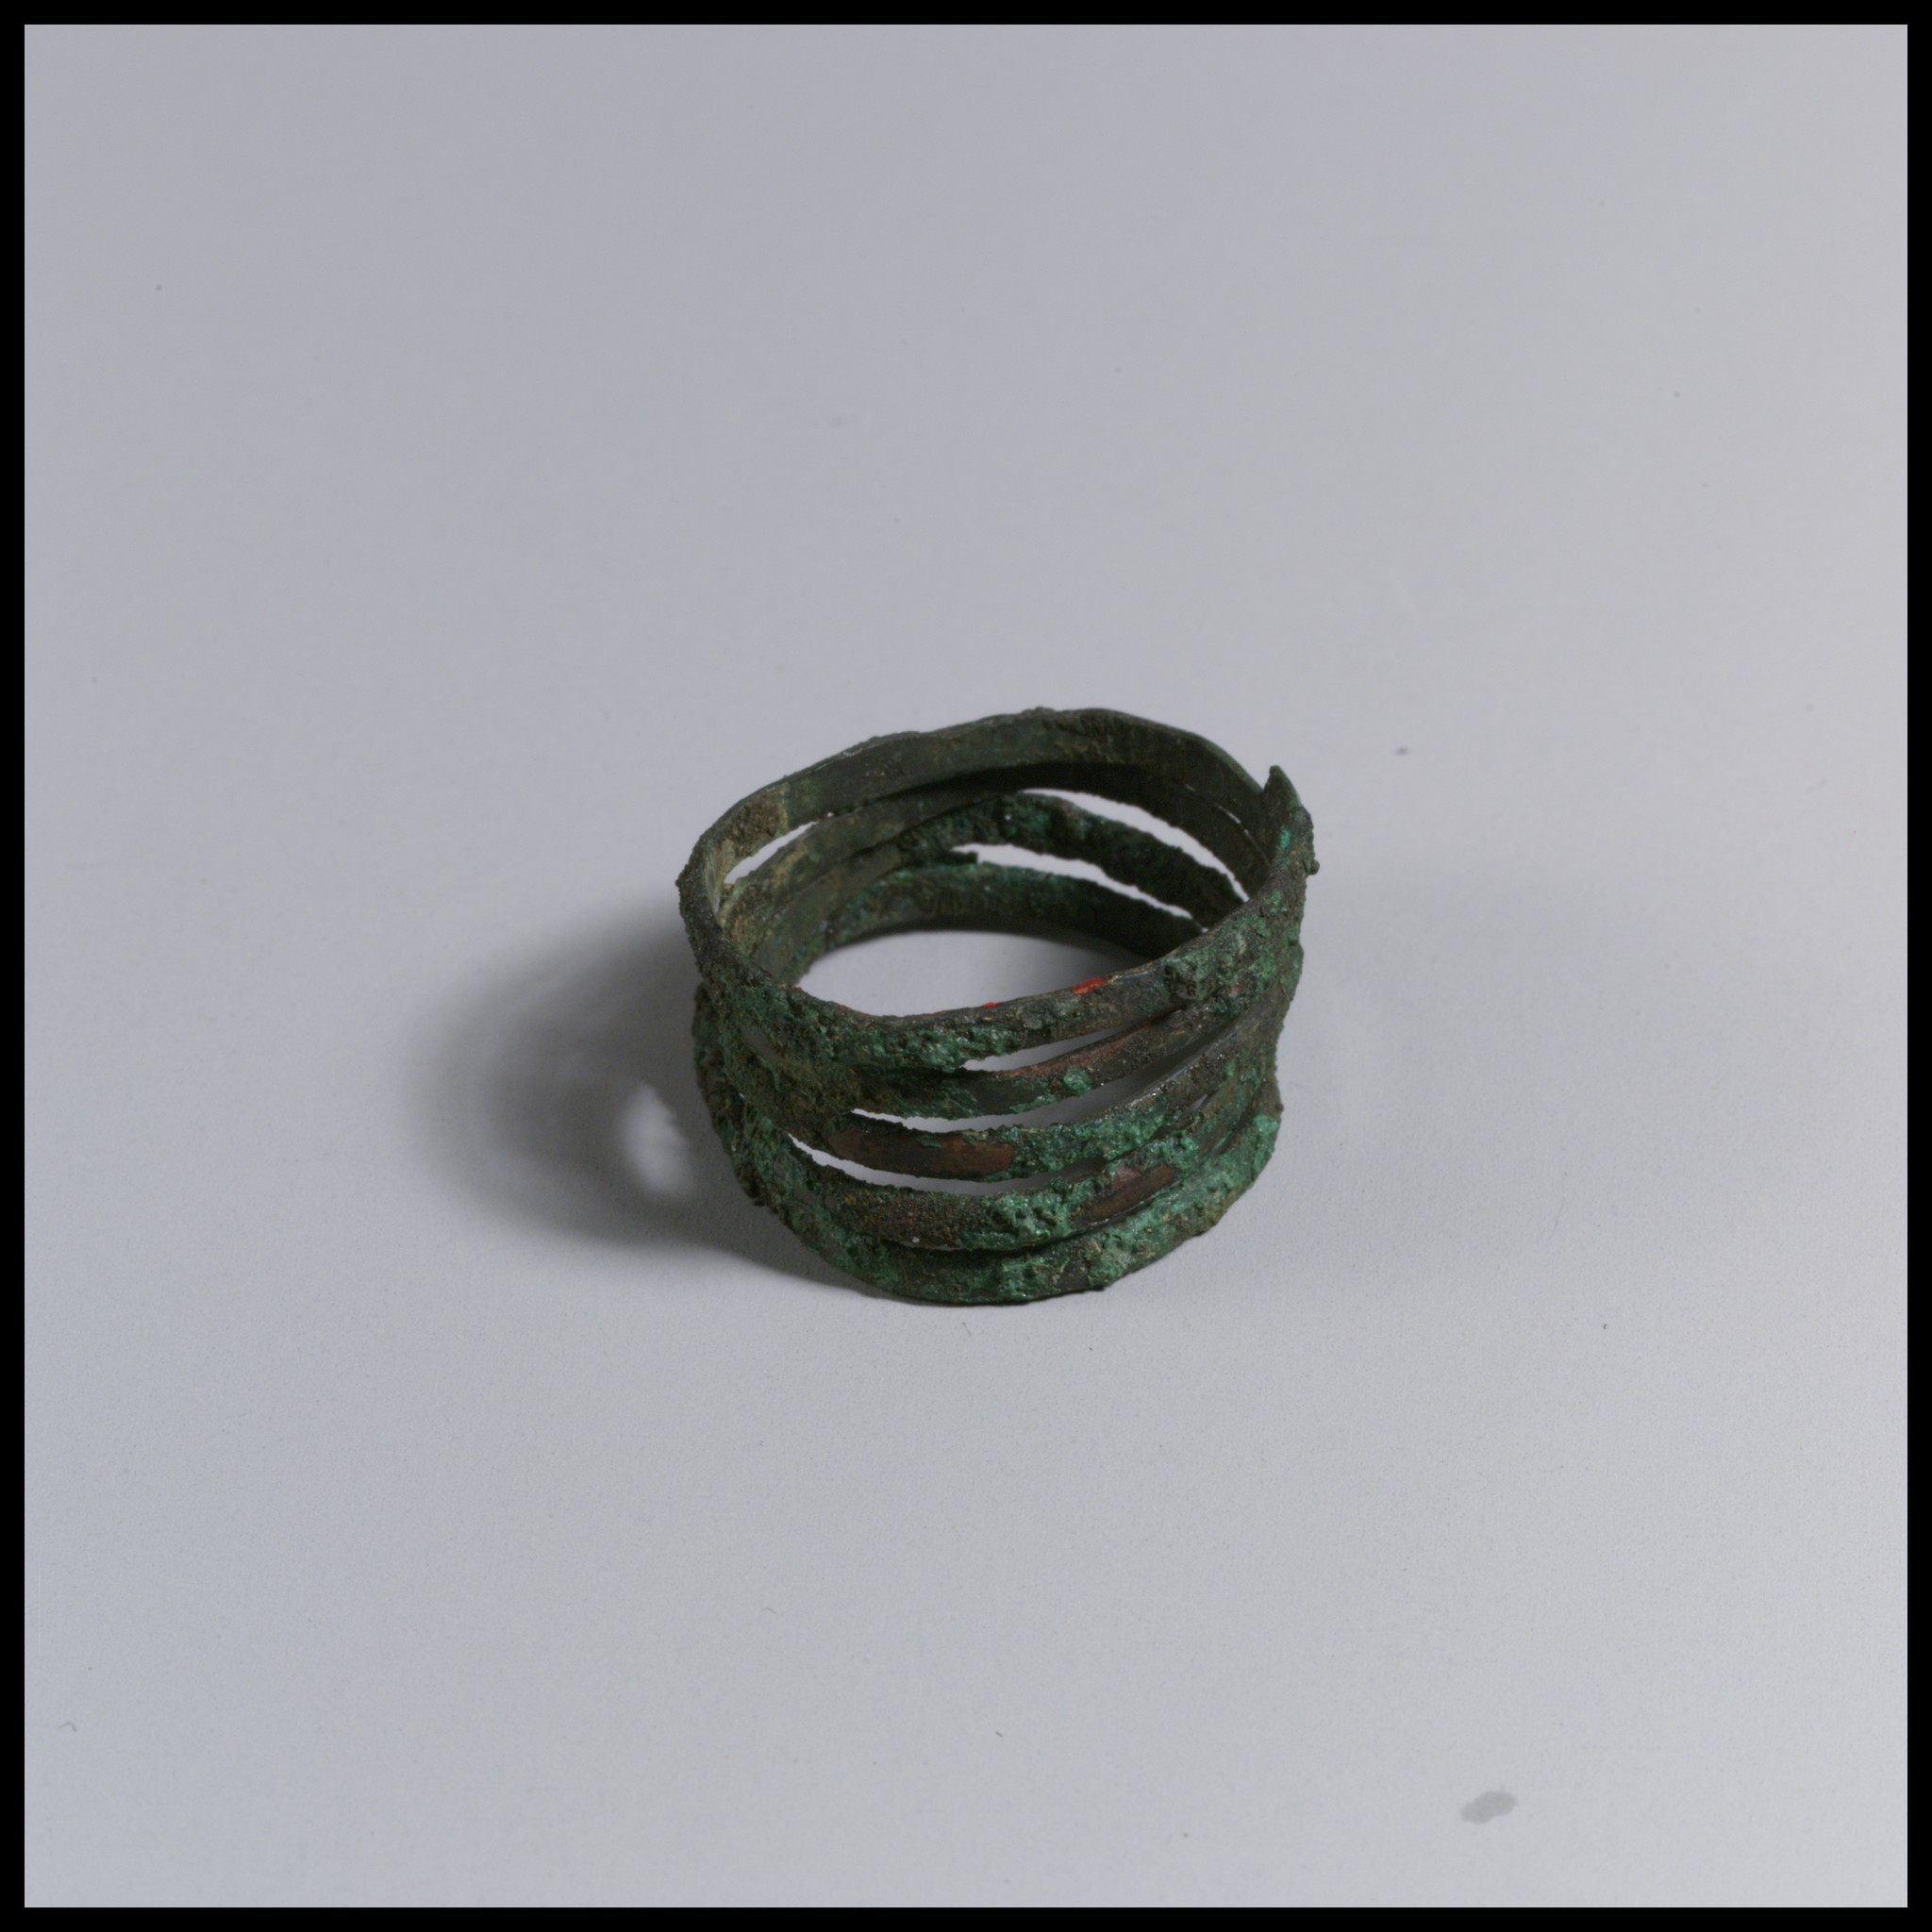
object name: ring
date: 7000 BCE-330 CE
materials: bronze